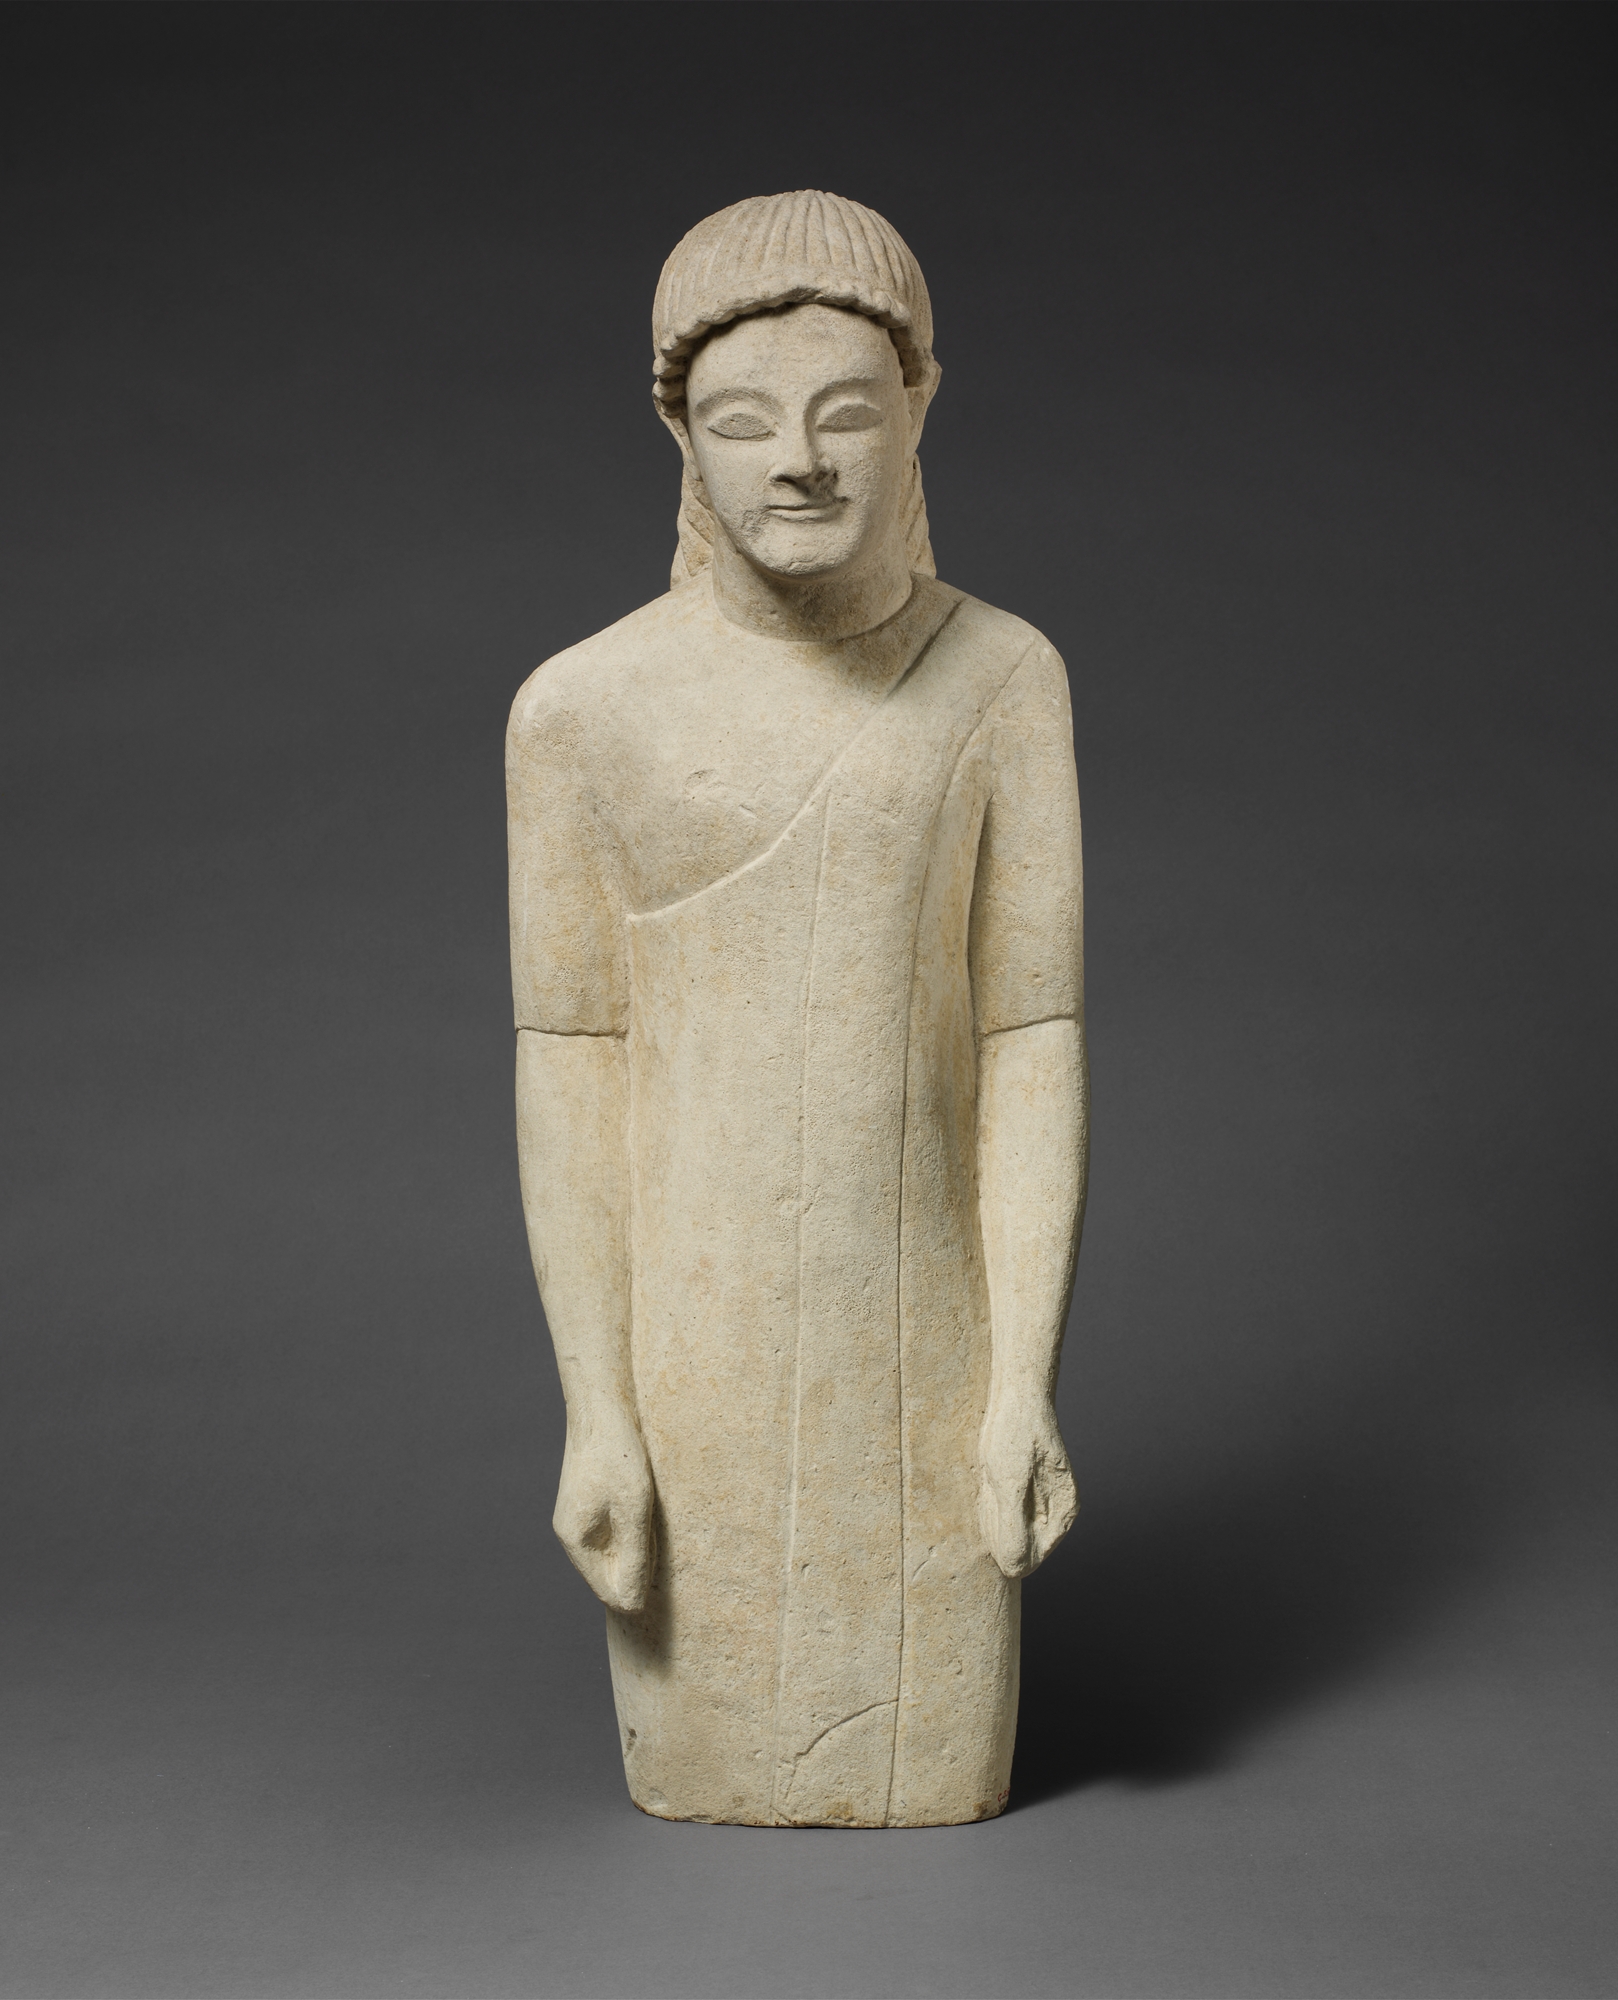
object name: statue of a votary, male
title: Limestone statuette of a beardless male votary in Greek dress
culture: cypriot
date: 534-501 BCE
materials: limestone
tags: men